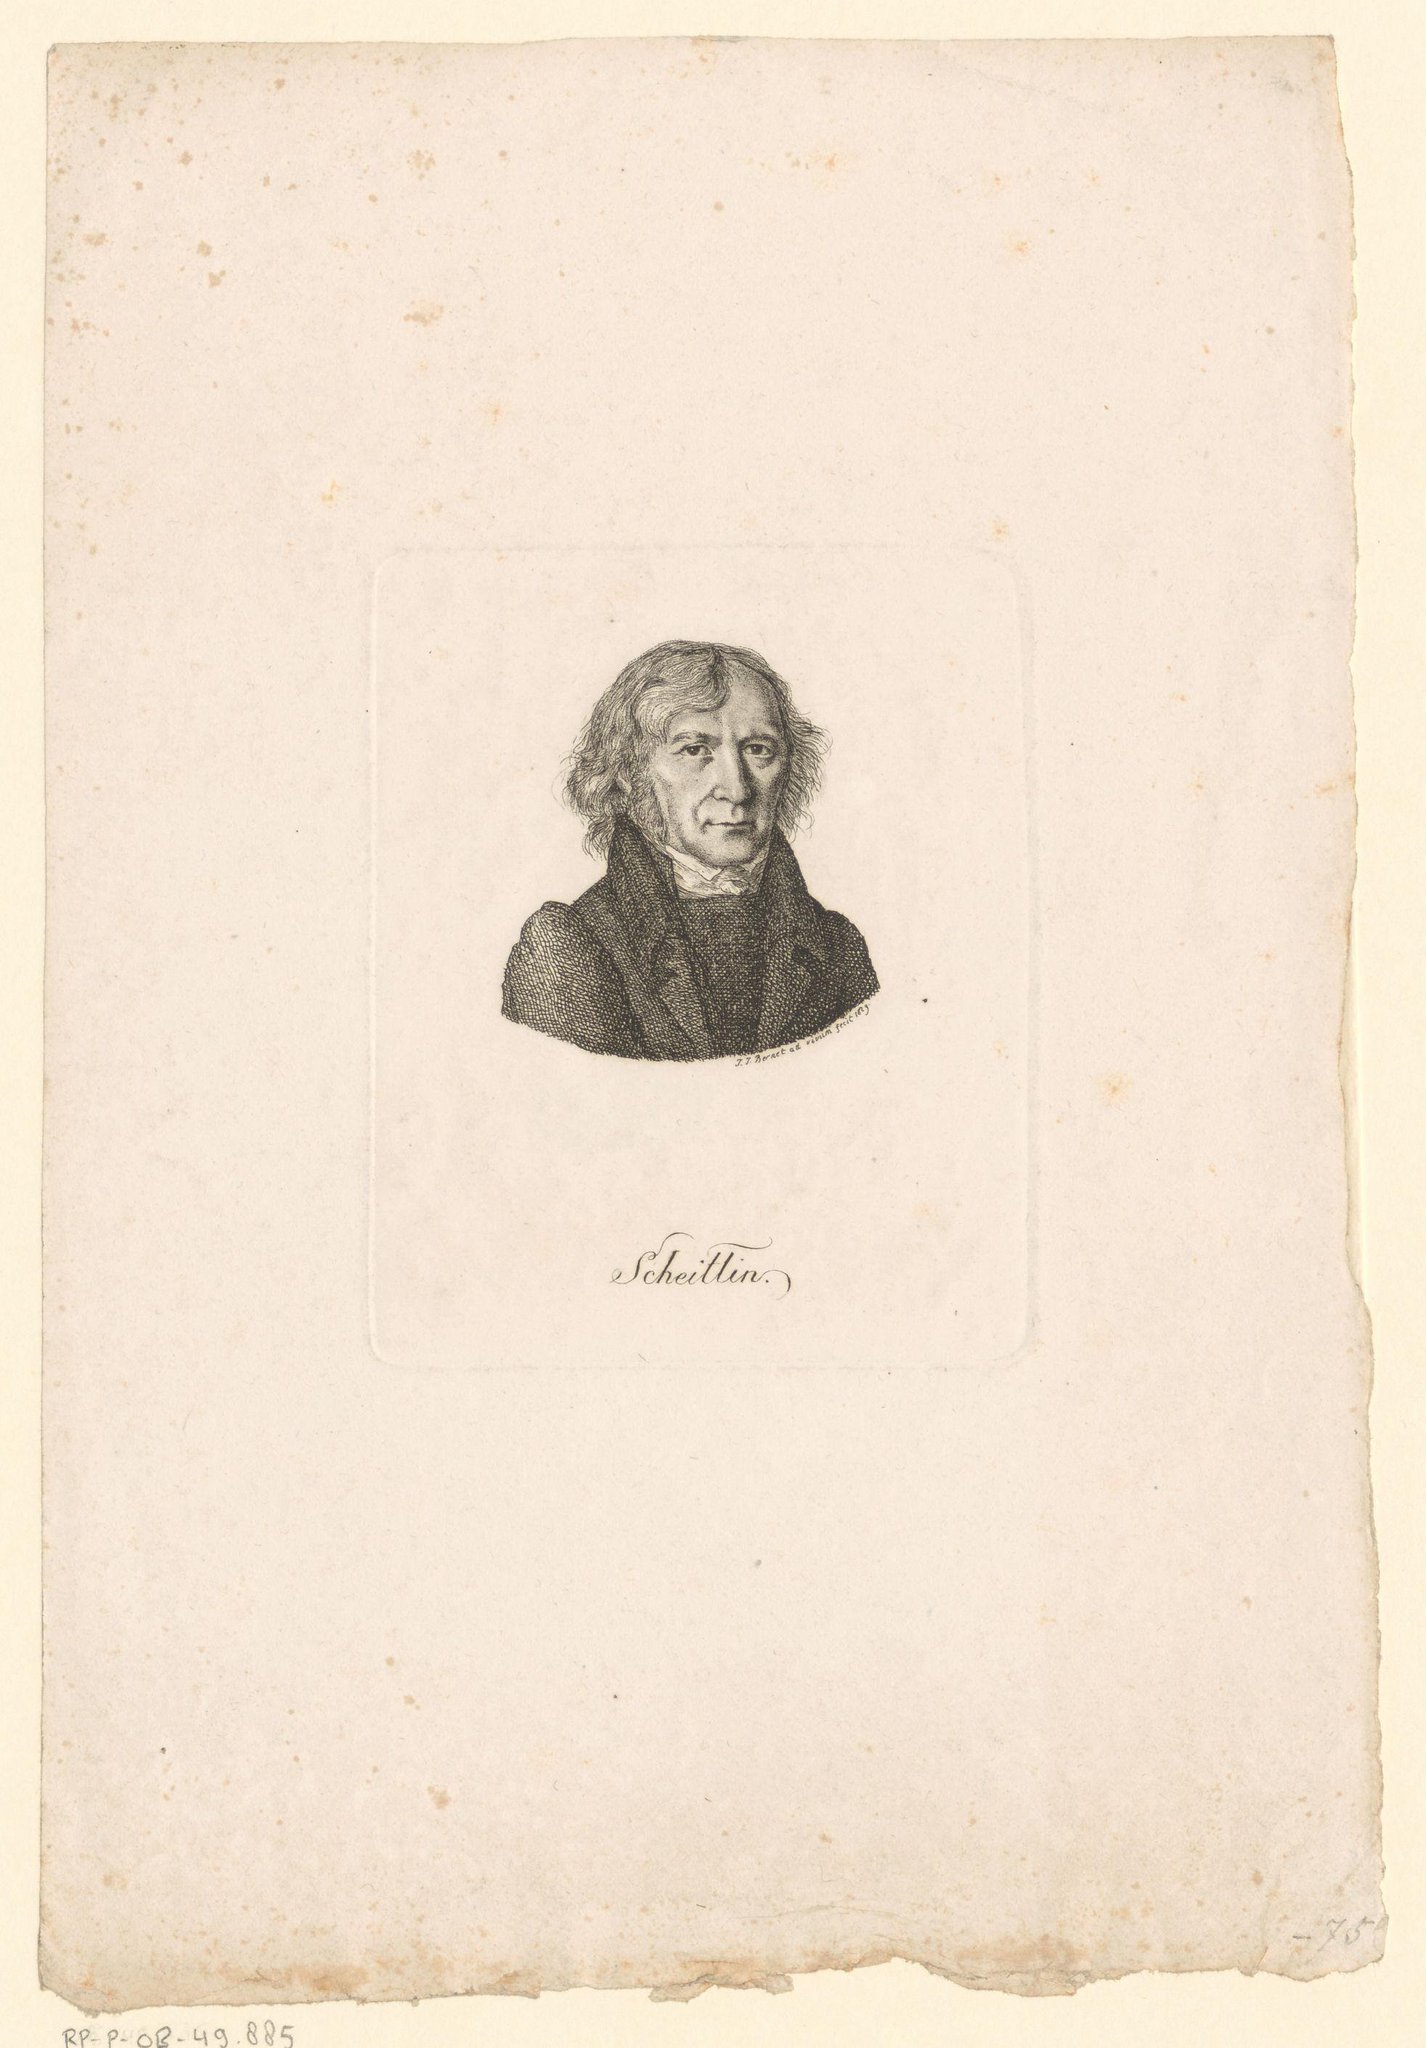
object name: print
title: Portret van Peter Scheitlin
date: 1829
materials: paper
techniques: etching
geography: sankt gallen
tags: historical persons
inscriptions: collector's mark: Lugt 2228